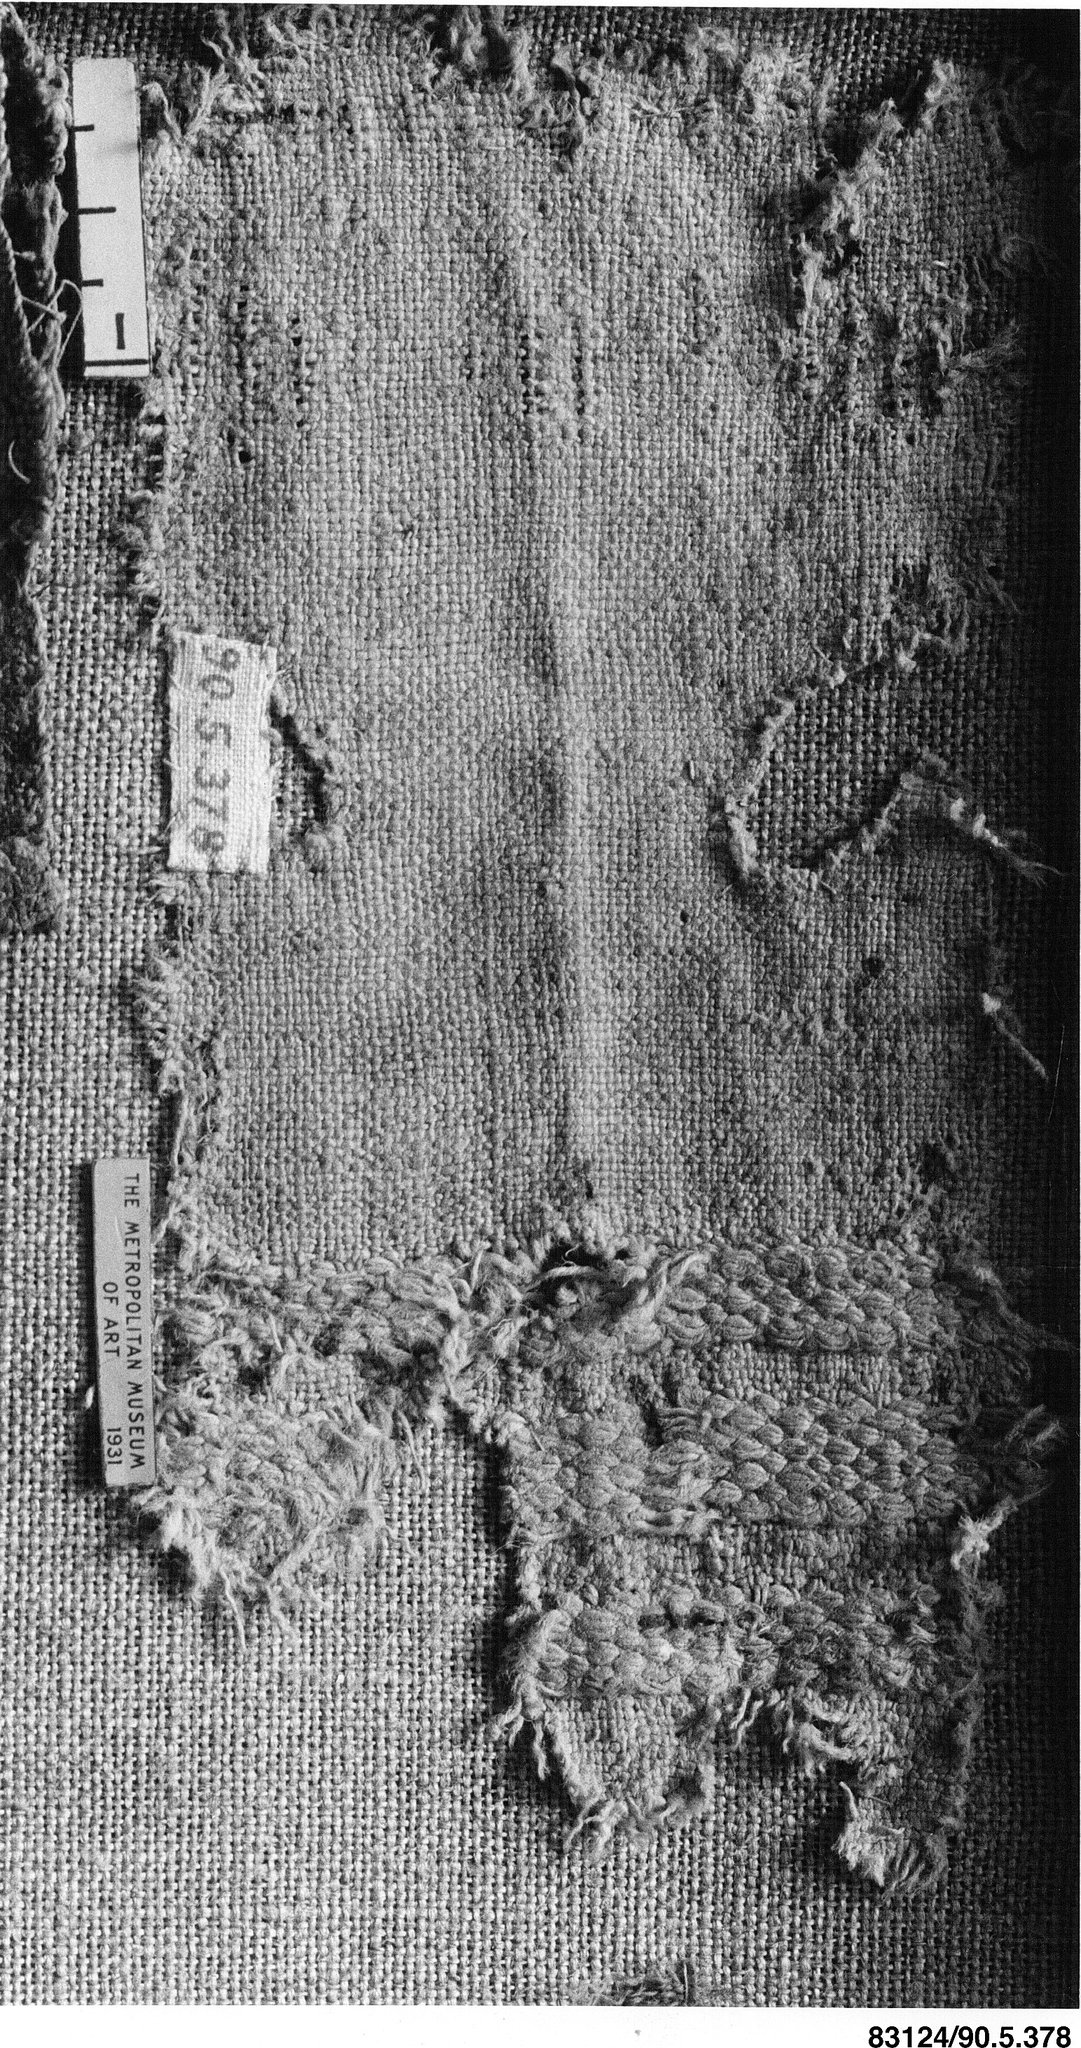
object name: textile fragment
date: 401-600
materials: linen, wool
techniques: weave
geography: egypt